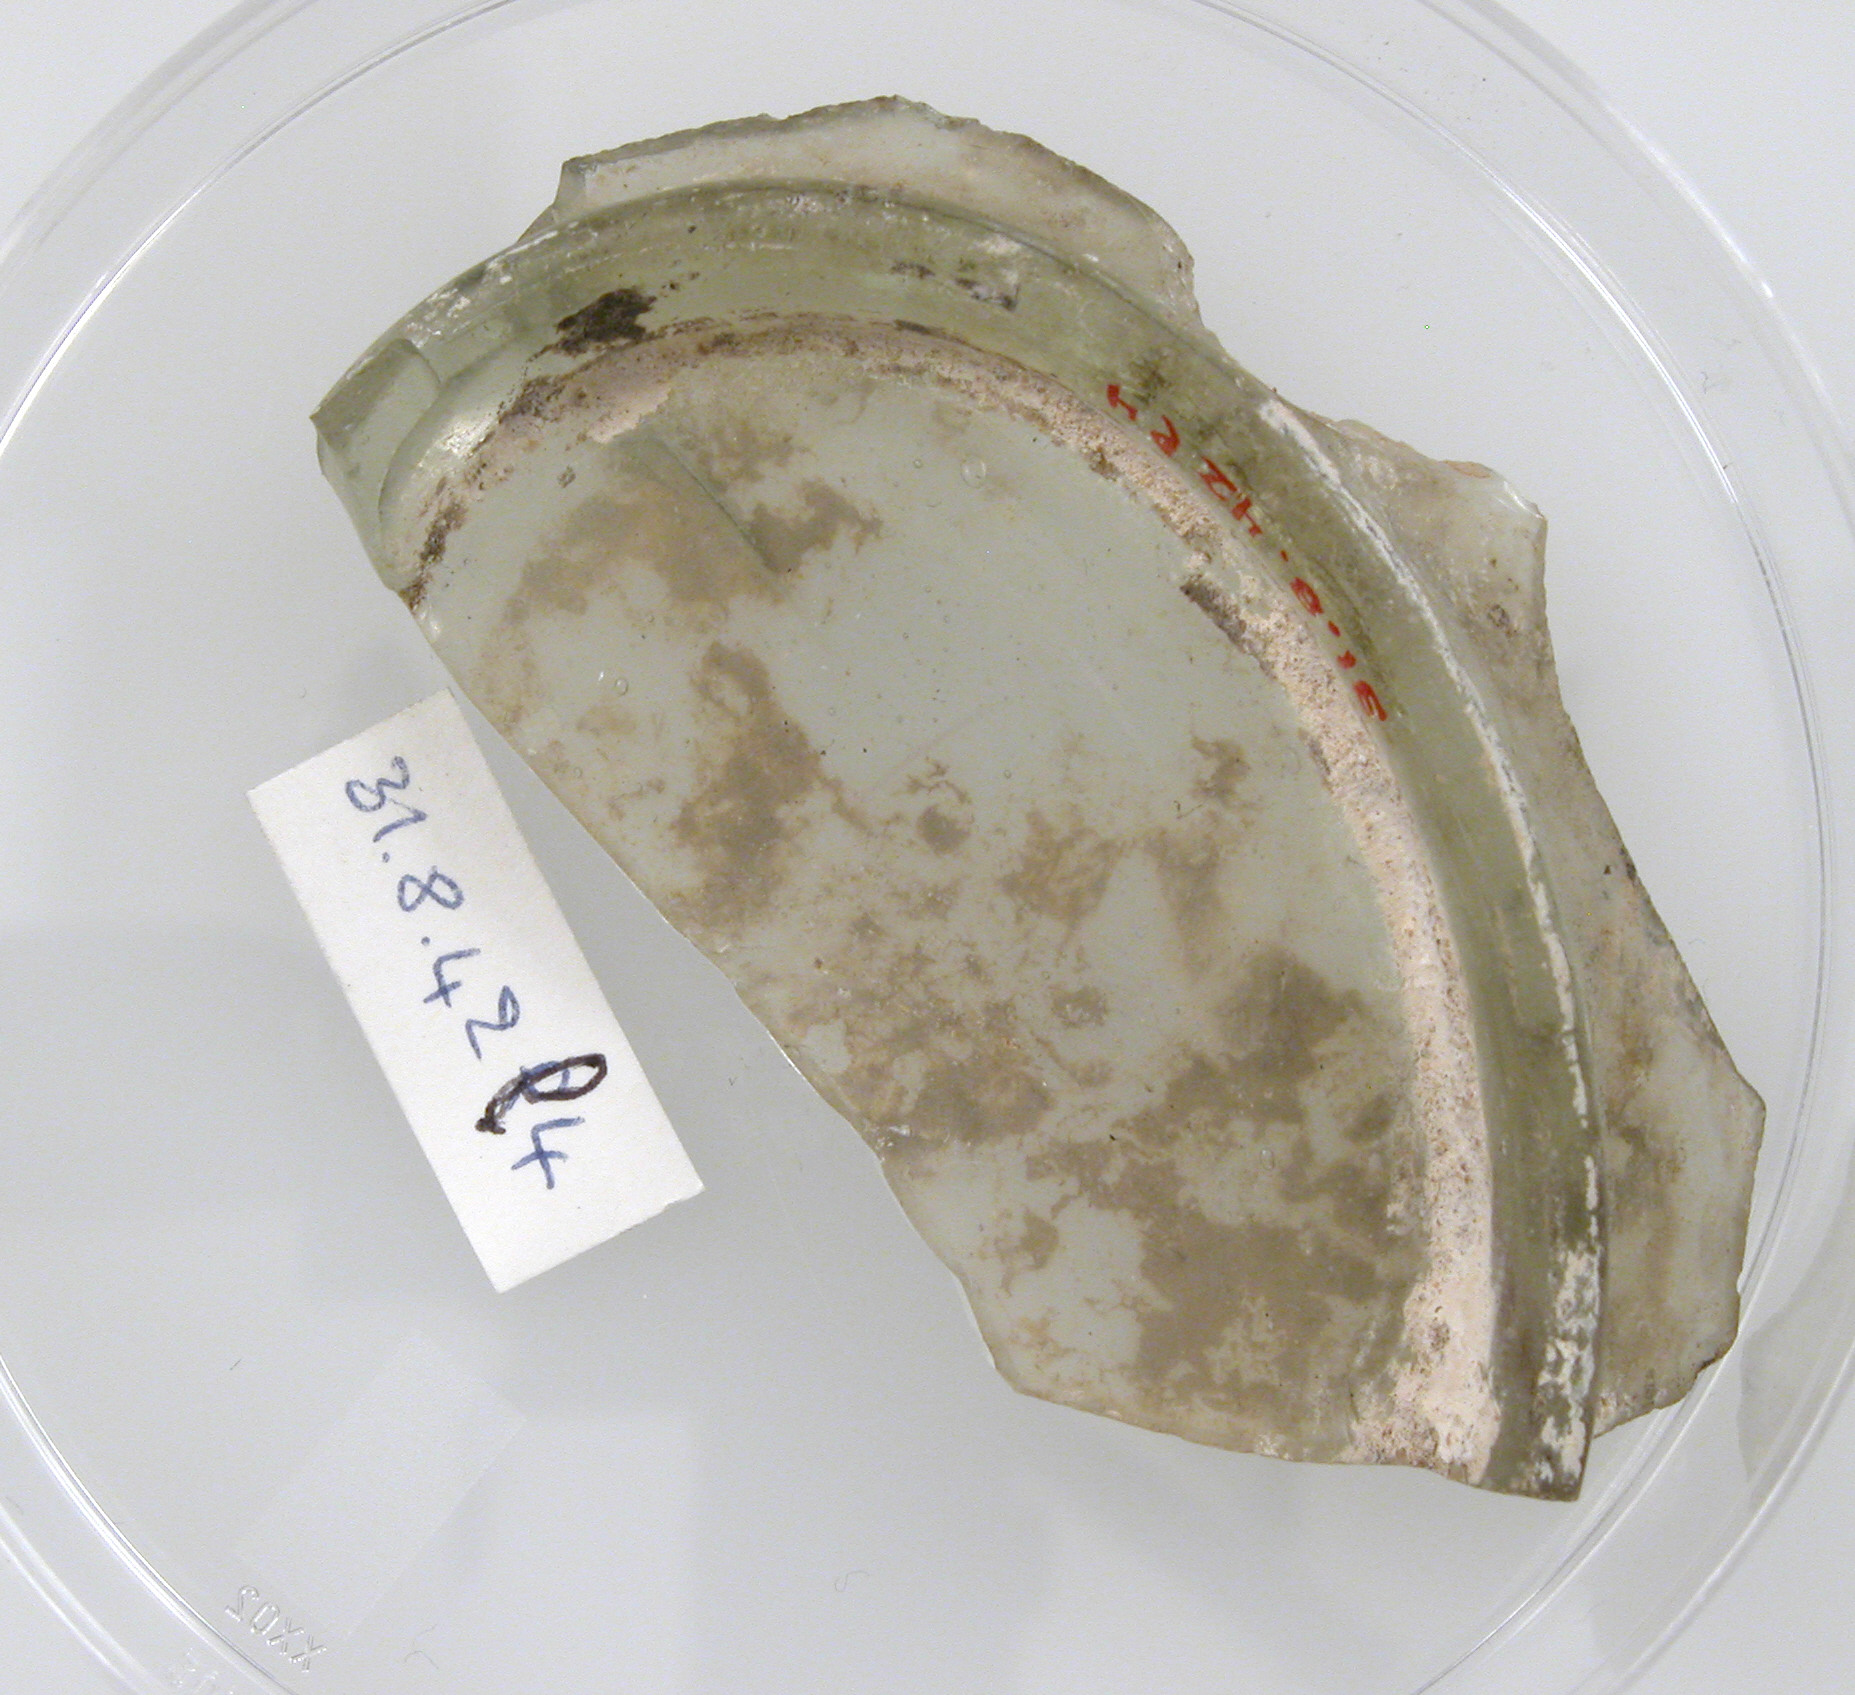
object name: fragment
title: Foot of a Vessel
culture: coptic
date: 301-400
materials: glass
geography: egypt